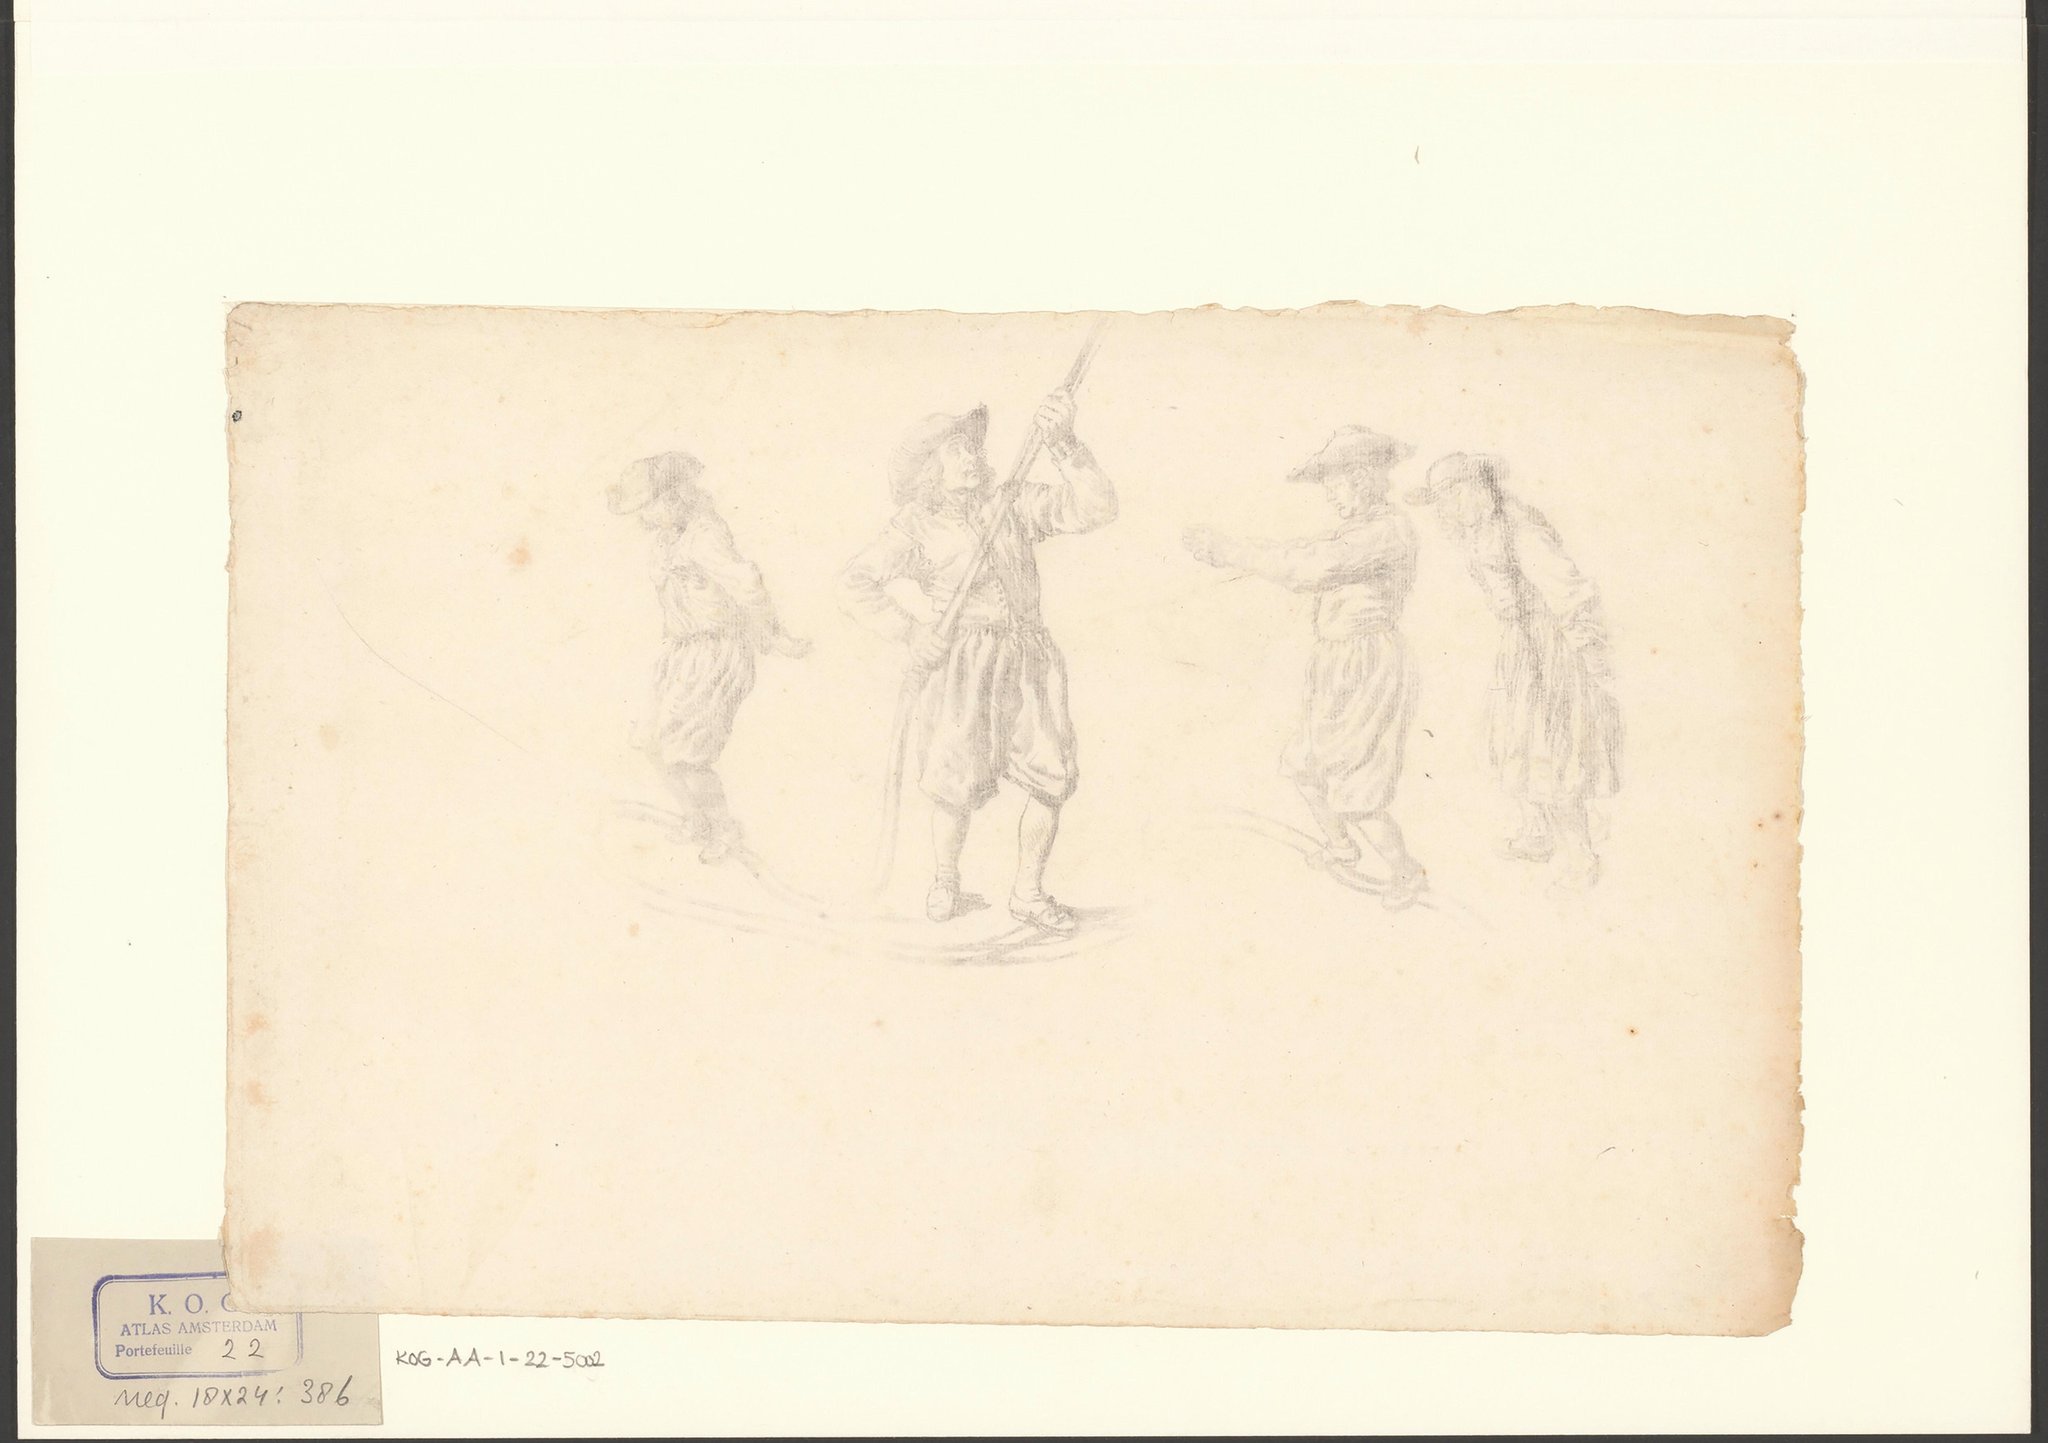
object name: drawing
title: Compositie met vier brandweermannen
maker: jan van der heyden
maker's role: draughtsman, painter, print maker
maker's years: 1637-1712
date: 1647-1690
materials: chalk, paper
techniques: printmaking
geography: amsterdam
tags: firemen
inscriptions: inscription: ‘Port. 22’, collector's mark: ‘22’ Lugt 1641b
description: Tegendruk van een ontwerptekening voor illustraties uit: Heyden, Jan van der. Beschryving der nieuwlyks uitgevonden en geoctrojeerde slang-brandspuiten, en haare wyze van brand-blussen (...). Amsterdam: Jan Rieuwertsz (II), 1690.